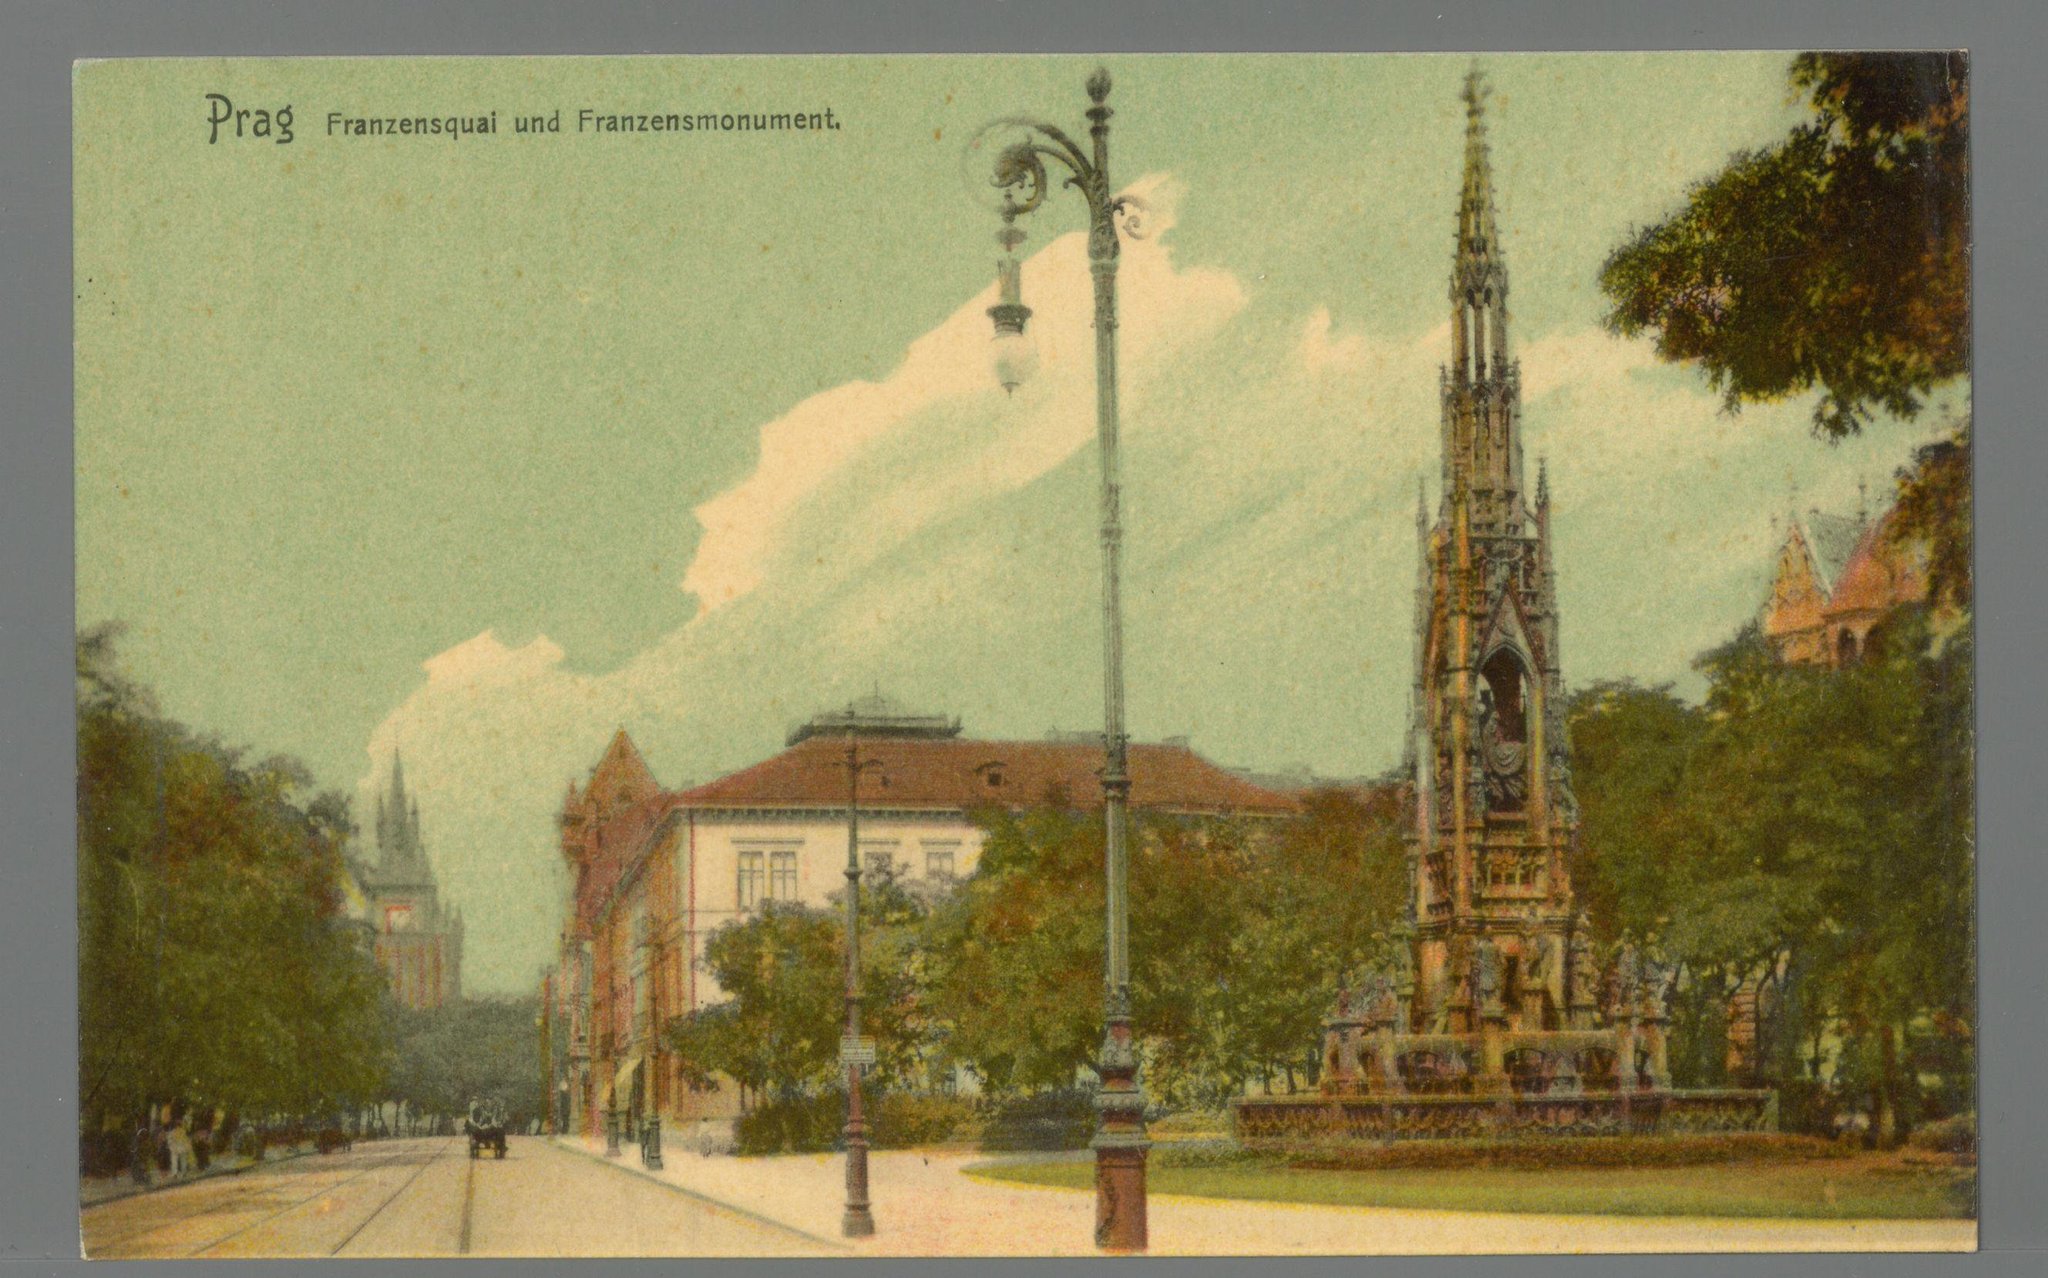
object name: photomechanical print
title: Prag. Franzensquai und Franzensmonument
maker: Anonymous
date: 1908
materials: cardboard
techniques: photograph, lithograph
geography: vienna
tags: monument, statue, quay, prague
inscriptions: date